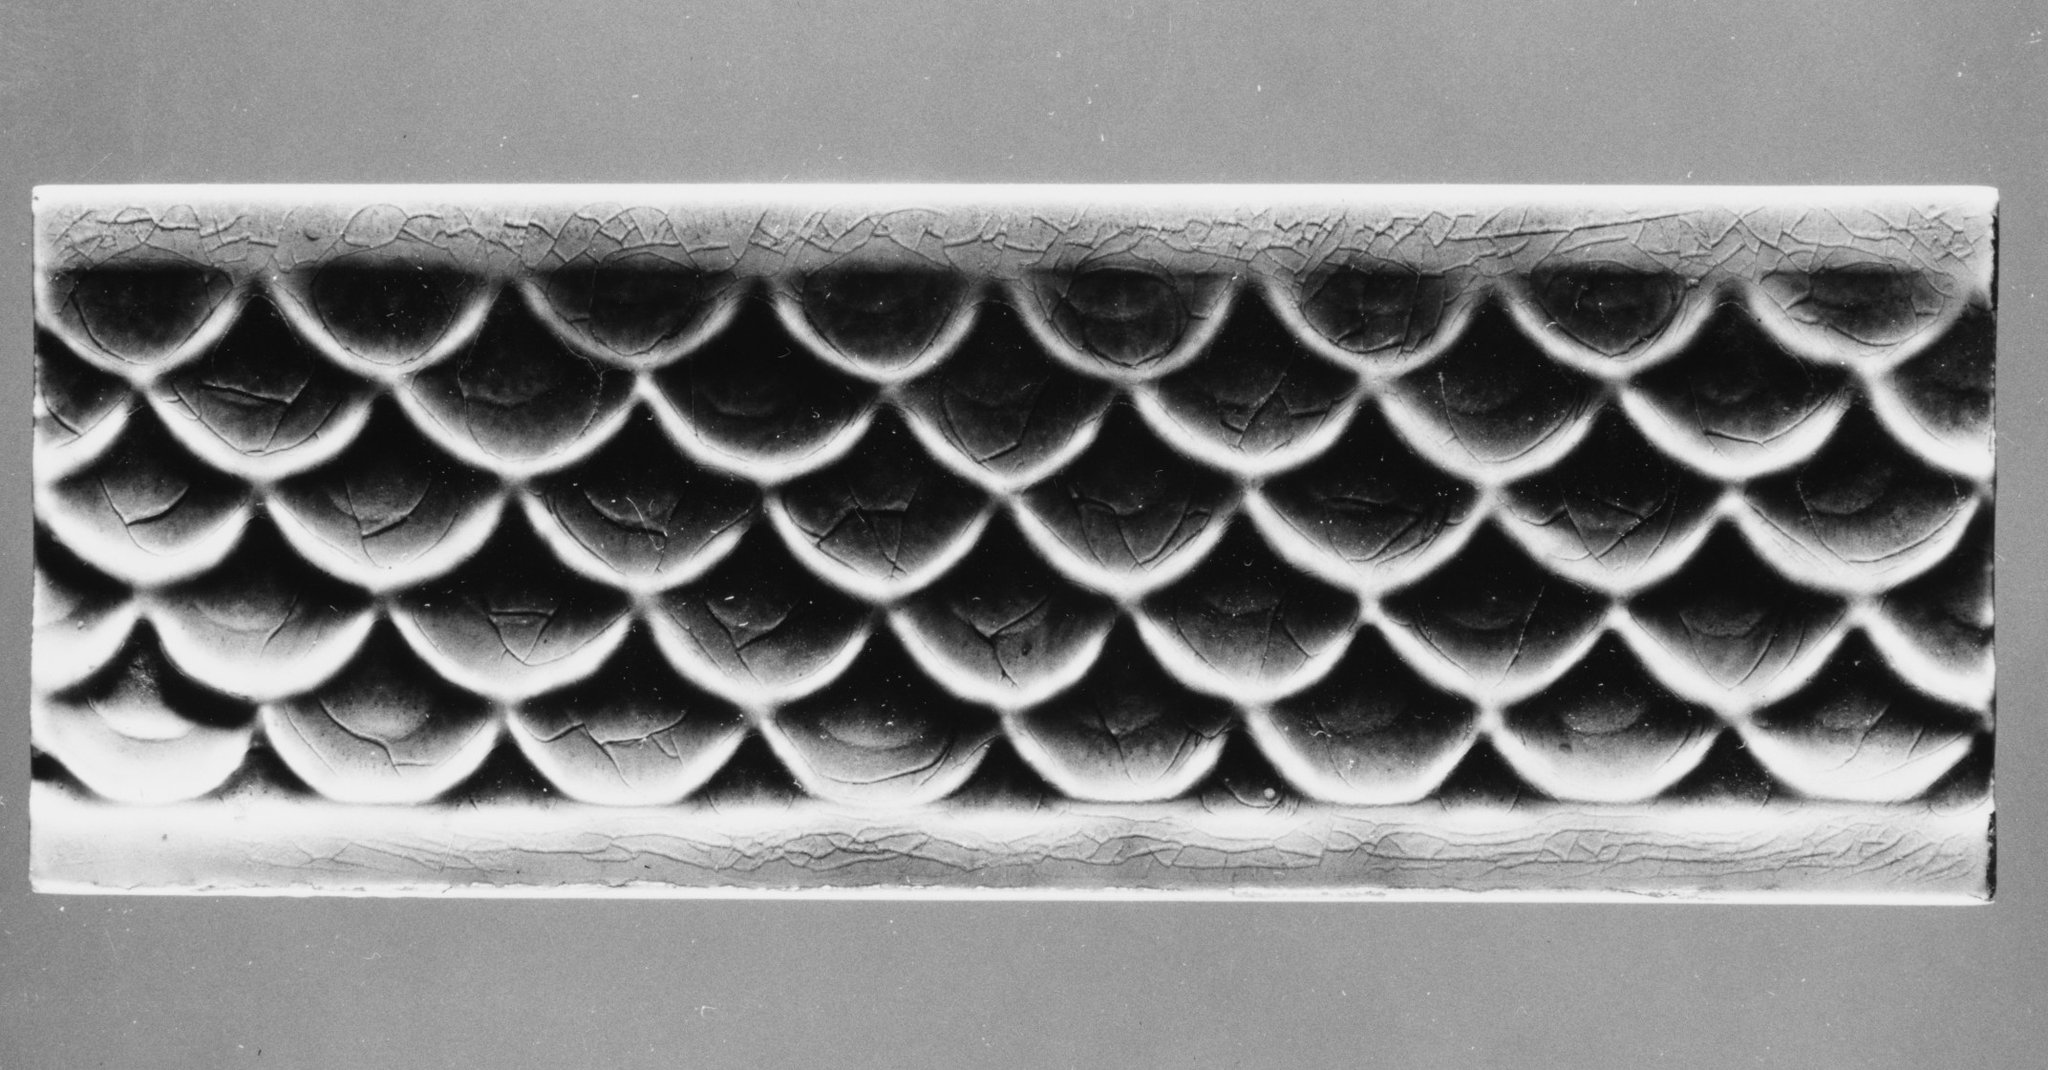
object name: tile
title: Border Tile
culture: american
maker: j. and j. g. low art tile works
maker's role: maker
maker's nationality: american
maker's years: 1877-1903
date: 1881-1884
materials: earthenware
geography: united states